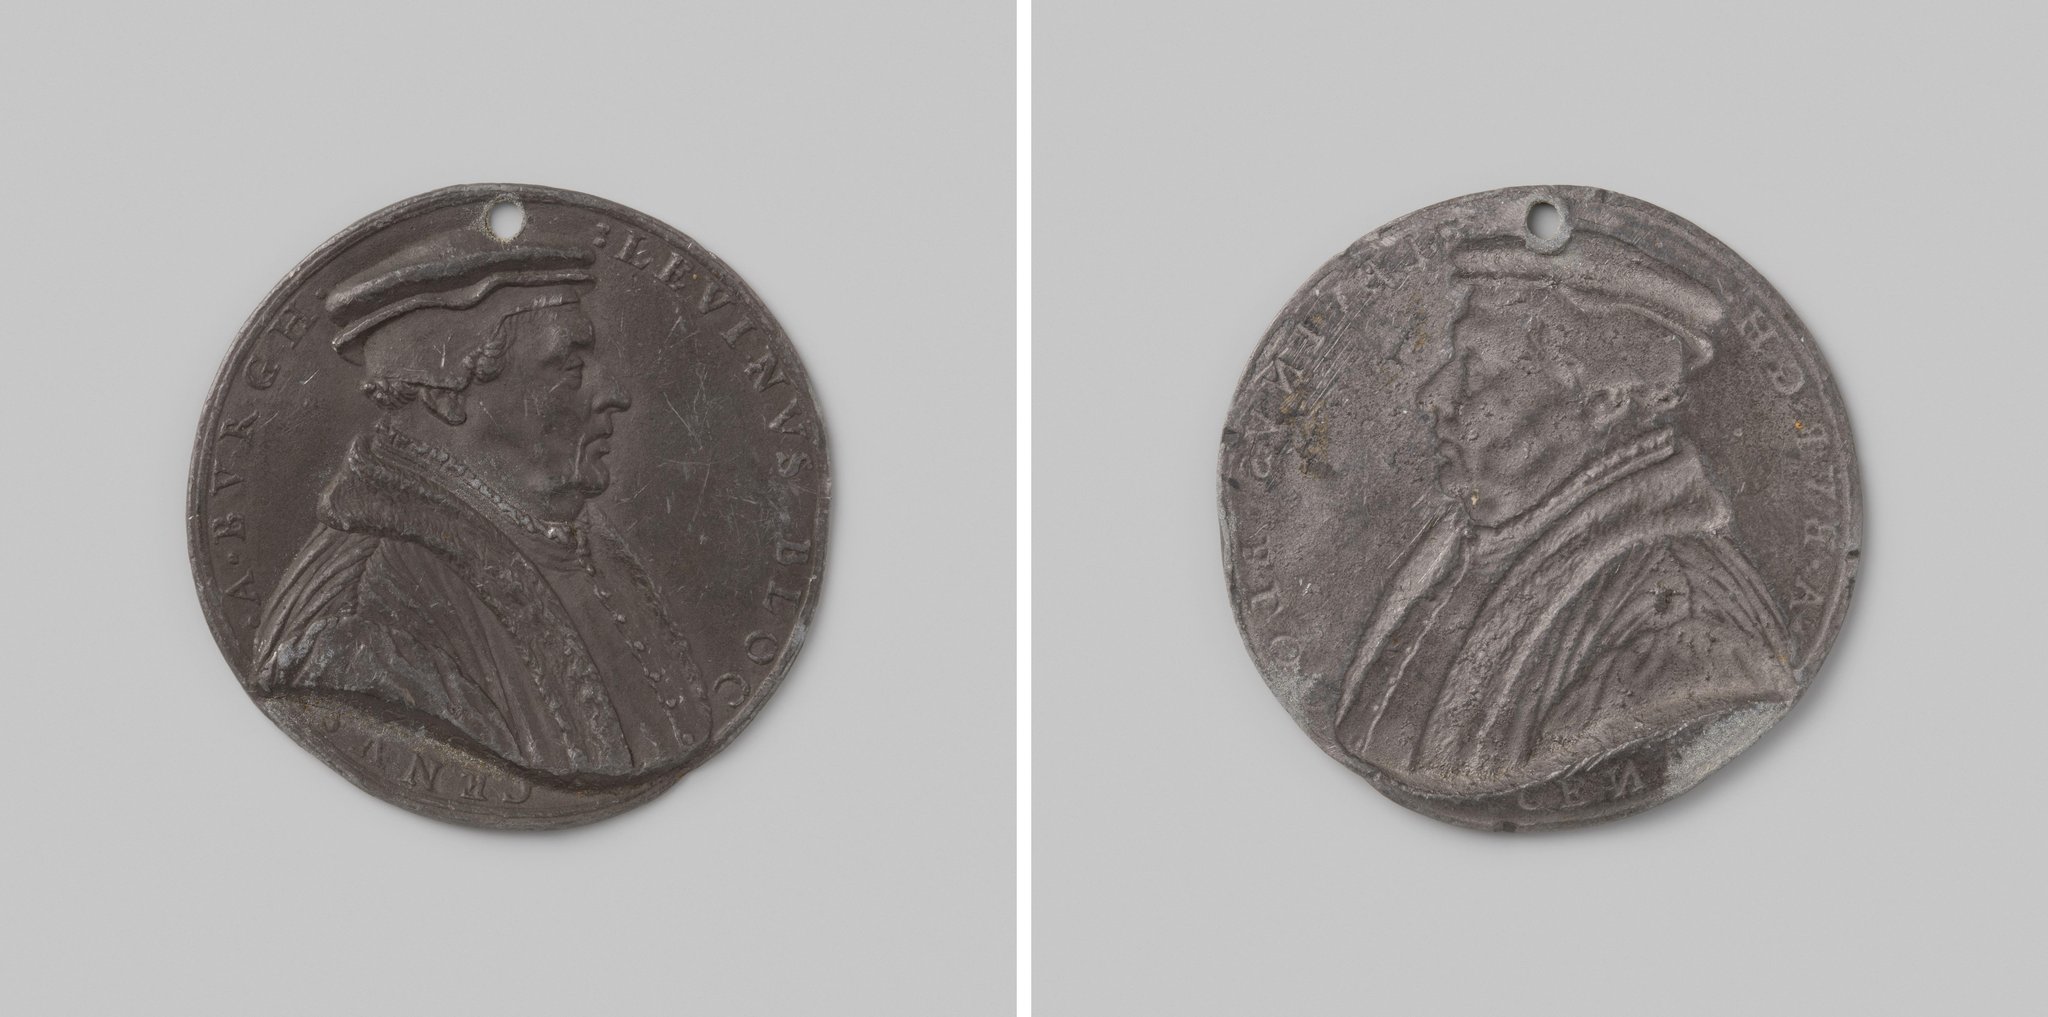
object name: history medal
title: Levinus Bloccenus a Burgh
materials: lead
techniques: casting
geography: middelburg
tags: levinus bloccenus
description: Eenzijdige loden penning met gat erin. Voorzijde: borststuk man binnen omschrift. Keerzijde: blanco.